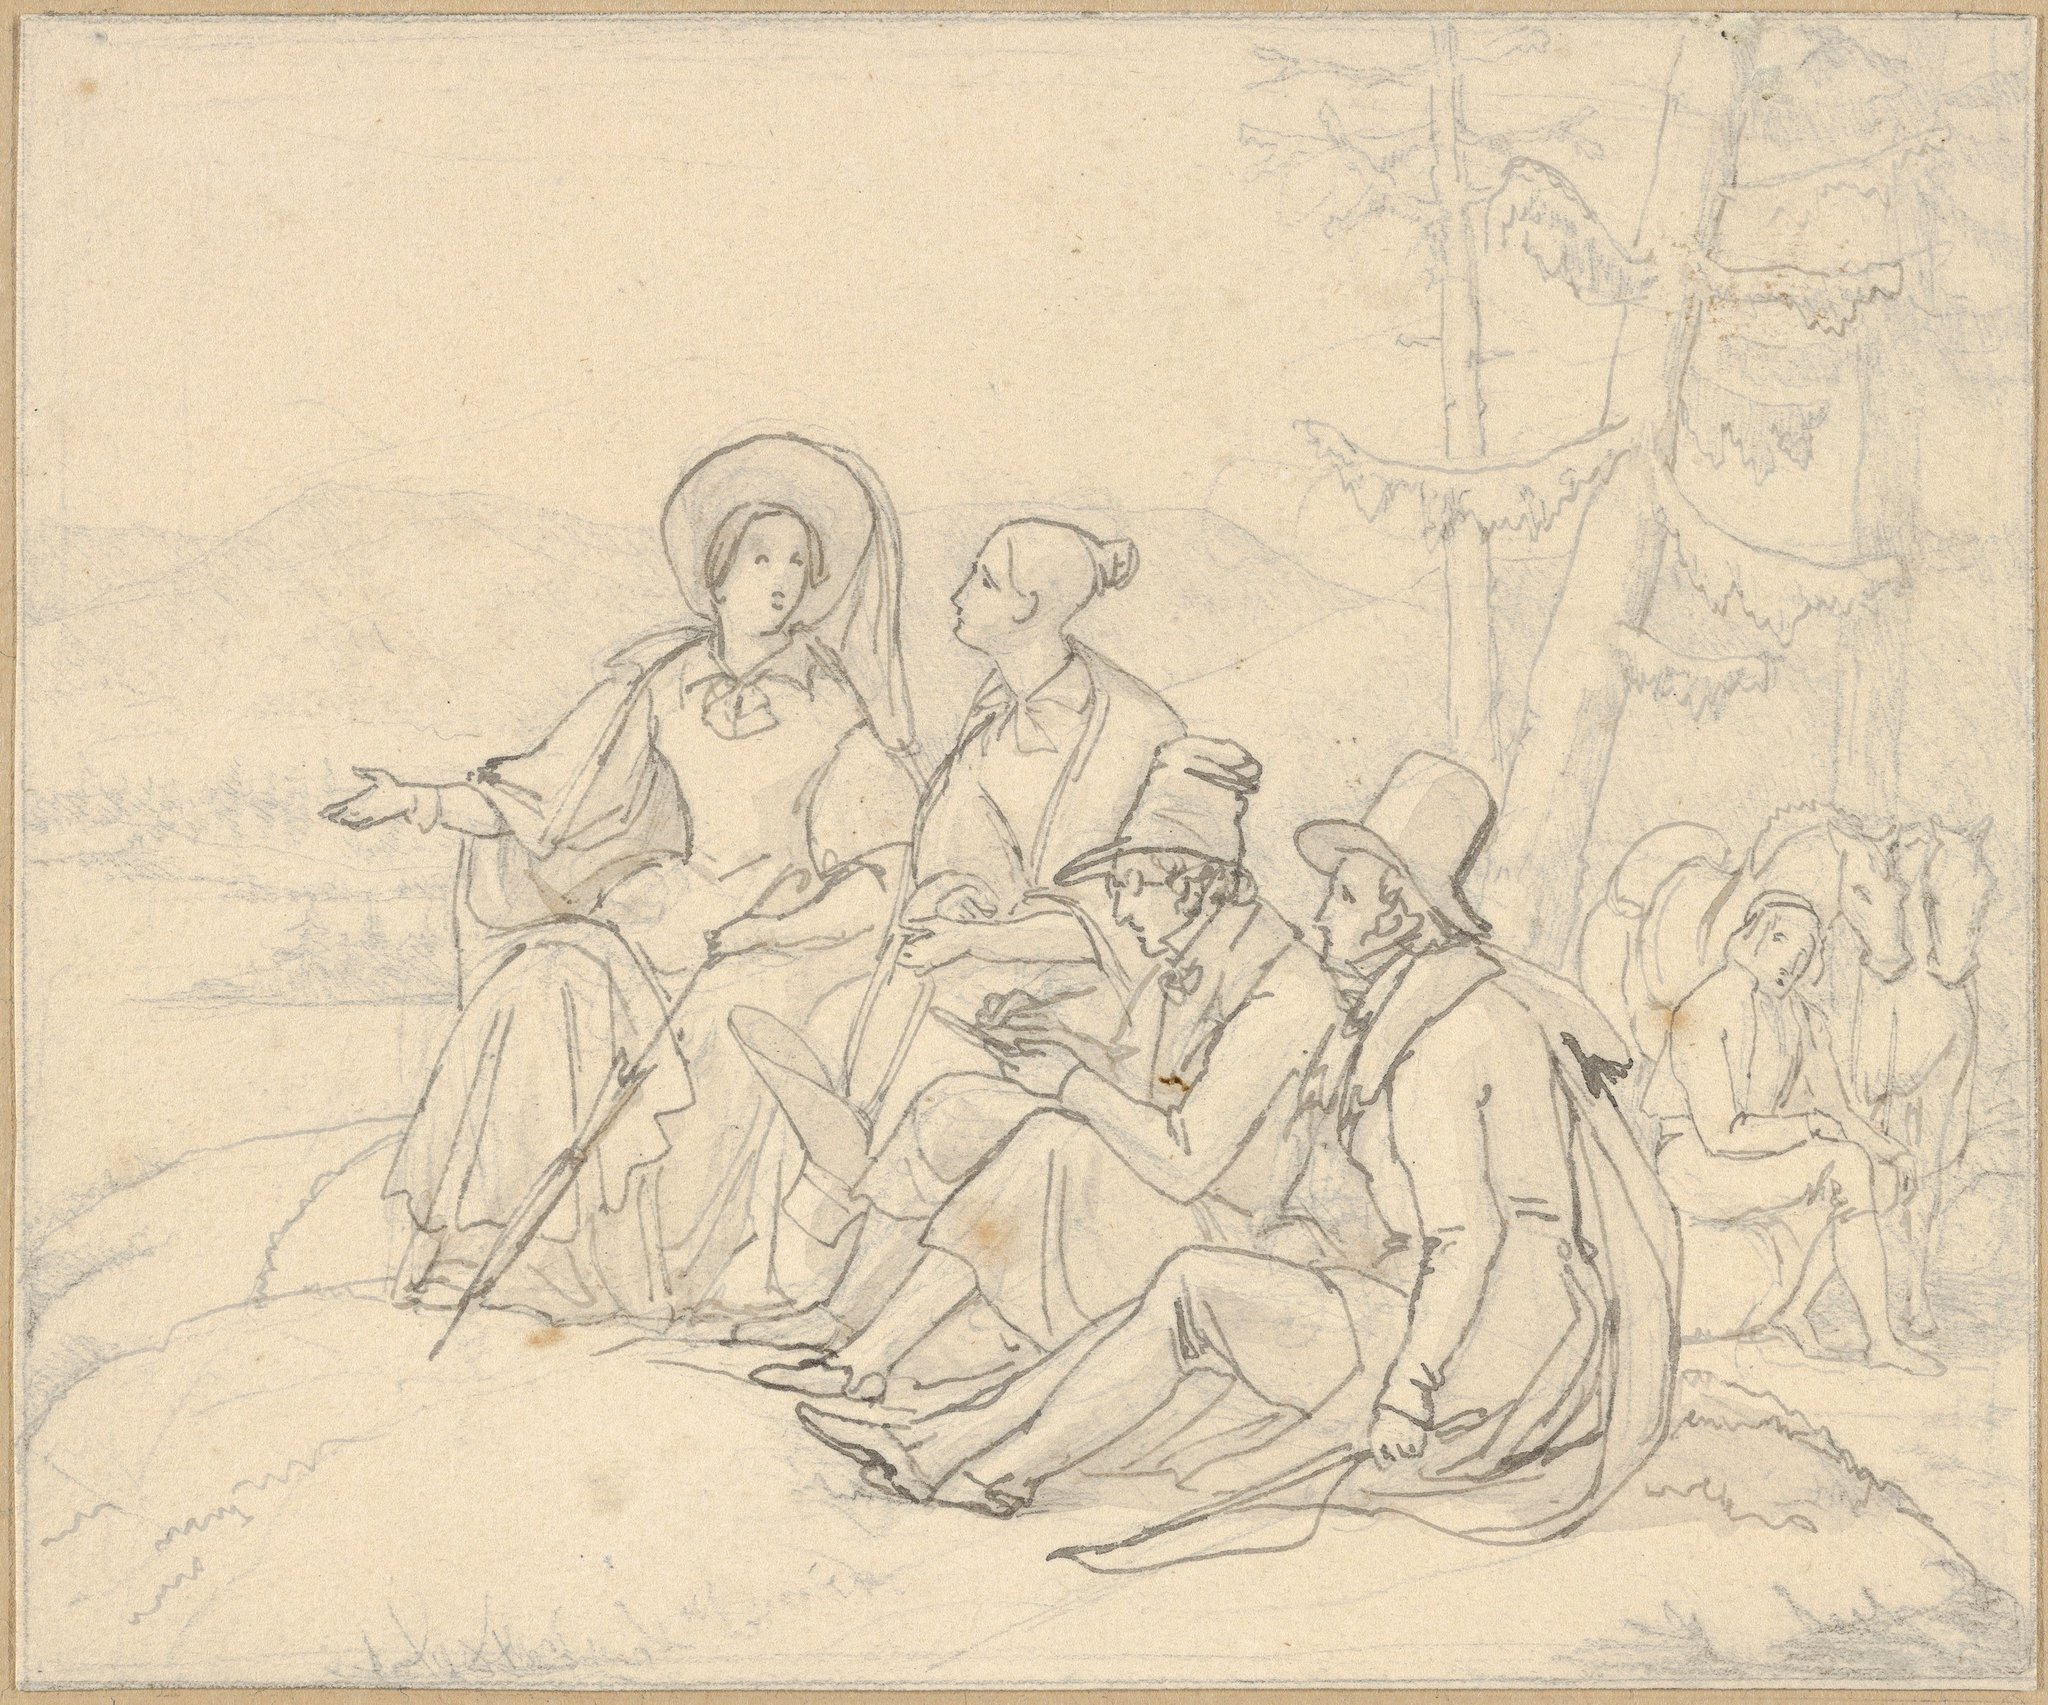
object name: drawing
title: Men and Women Enjoying a View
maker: martinus rørbye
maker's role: artist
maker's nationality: danish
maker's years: 1803-1848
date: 1823-1848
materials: graphite, ink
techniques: pen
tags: men,women,horses